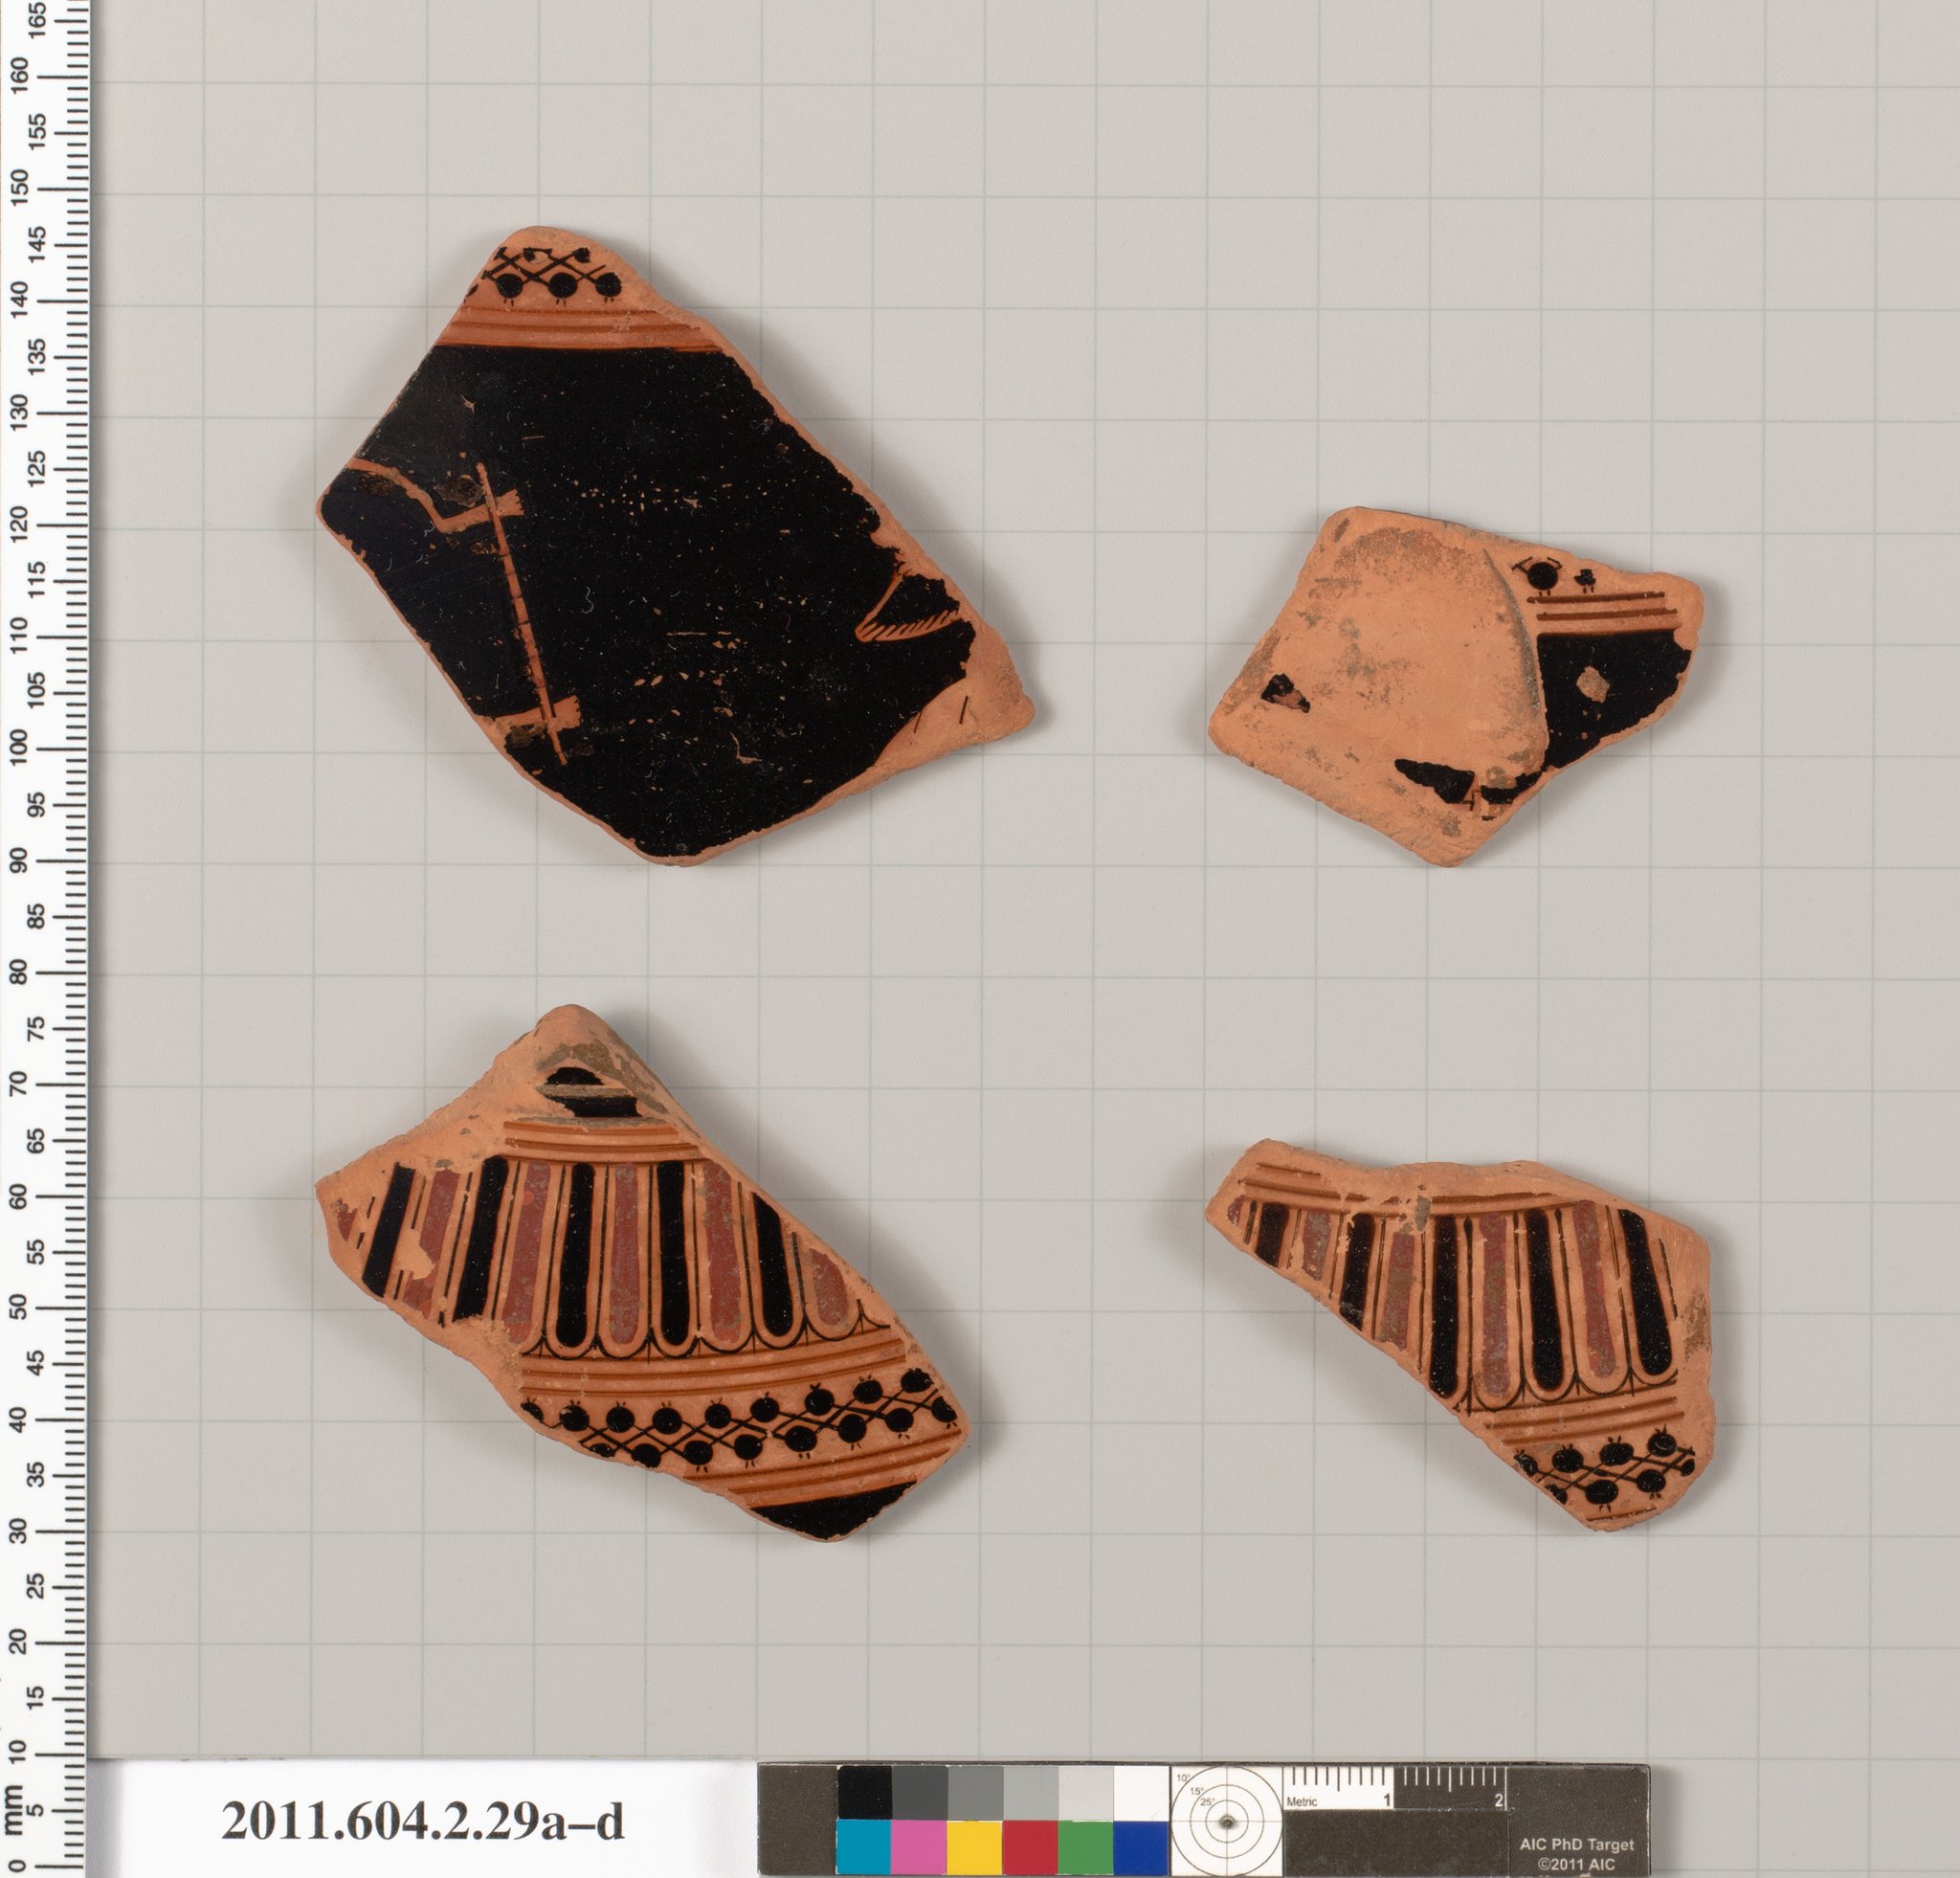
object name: psykter fragment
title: Terracotta fragments of a psykter (vase for cooling wine)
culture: greek, attic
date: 530-520 BCE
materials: terracotta